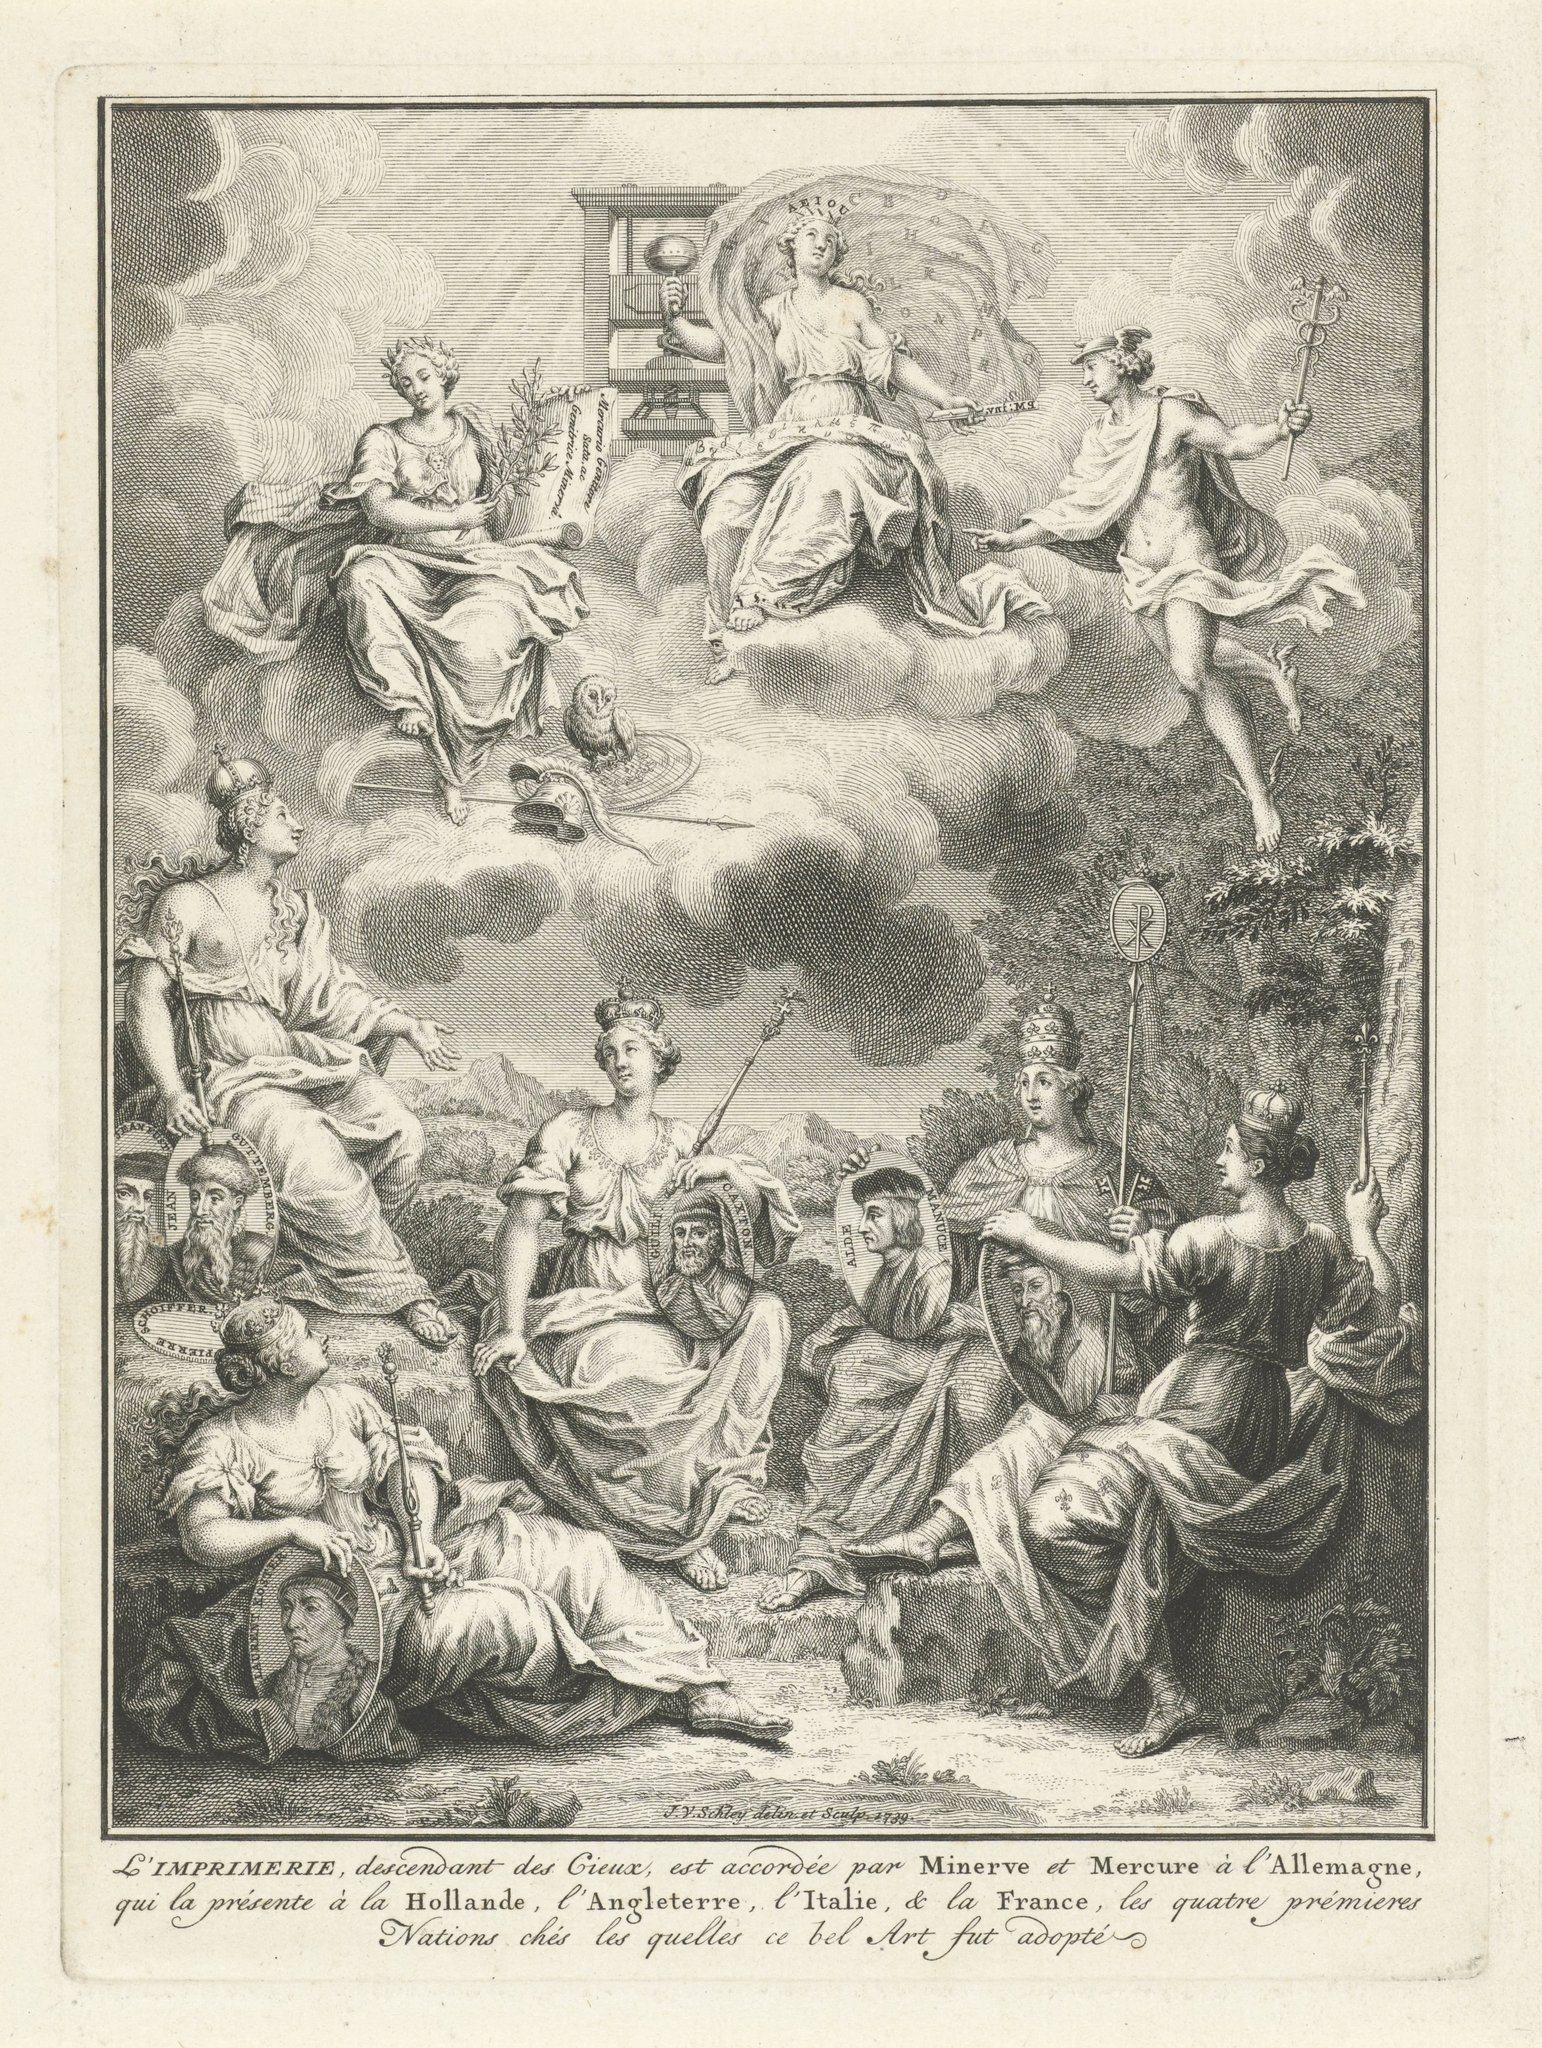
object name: titelblad, titelpagina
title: Titelpagina van Prosper Marchand, Histoire de l'origine de l'imprimerie, 1740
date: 1740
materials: paper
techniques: engraving, etching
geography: the hague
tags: printer, johannes gutenberg, venice, minerva as patroness, (story of) mercury (hermes), printing press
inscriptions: collector's mark: Lugt 240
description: Titelpagina van "Histoire de l'origine de l'imprimerie" van Prosper Marchand, 1740. Op een wolk zit een personificatie van de boekdrukkunst met een drukpers. Zij is geflankeerd door Minerva en Mercurius. Onder hen bevinden zich personificaties van Duitsland, Holland, Engeland, Italië en Frankrijk. Zij dragen portretten bij zich van personen die belangrijk zijn geweest voor de boekdrukkunst.